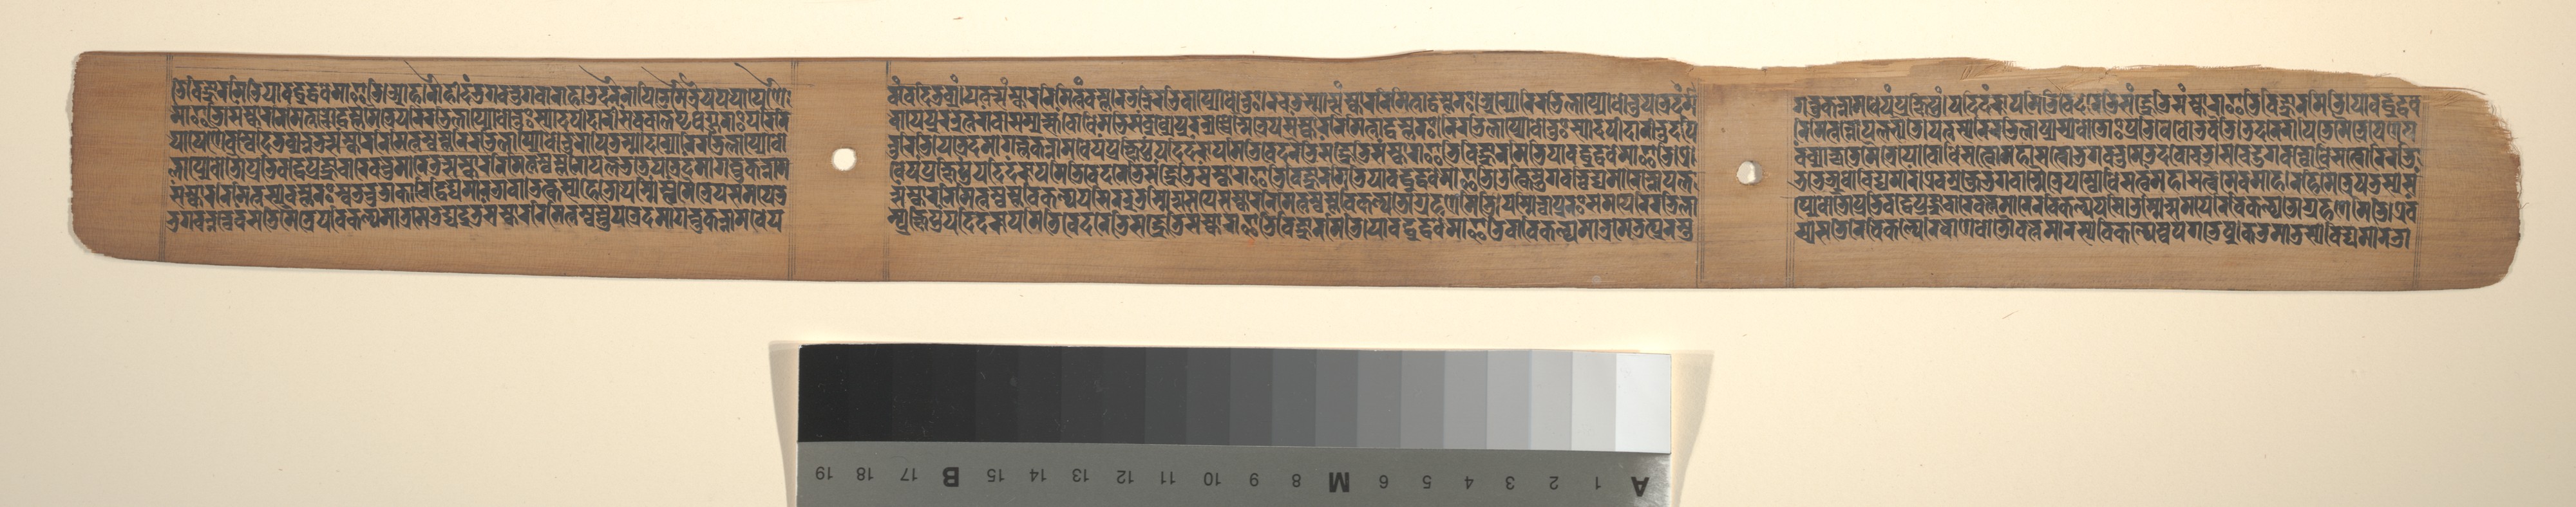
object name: folio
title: Folio from a Buddhist Manuscript of Pancavimsatisahasrika Prajnaparamita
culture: indian, bengal or bangladesh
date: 1090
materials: leaf, watercolor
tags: buddhism